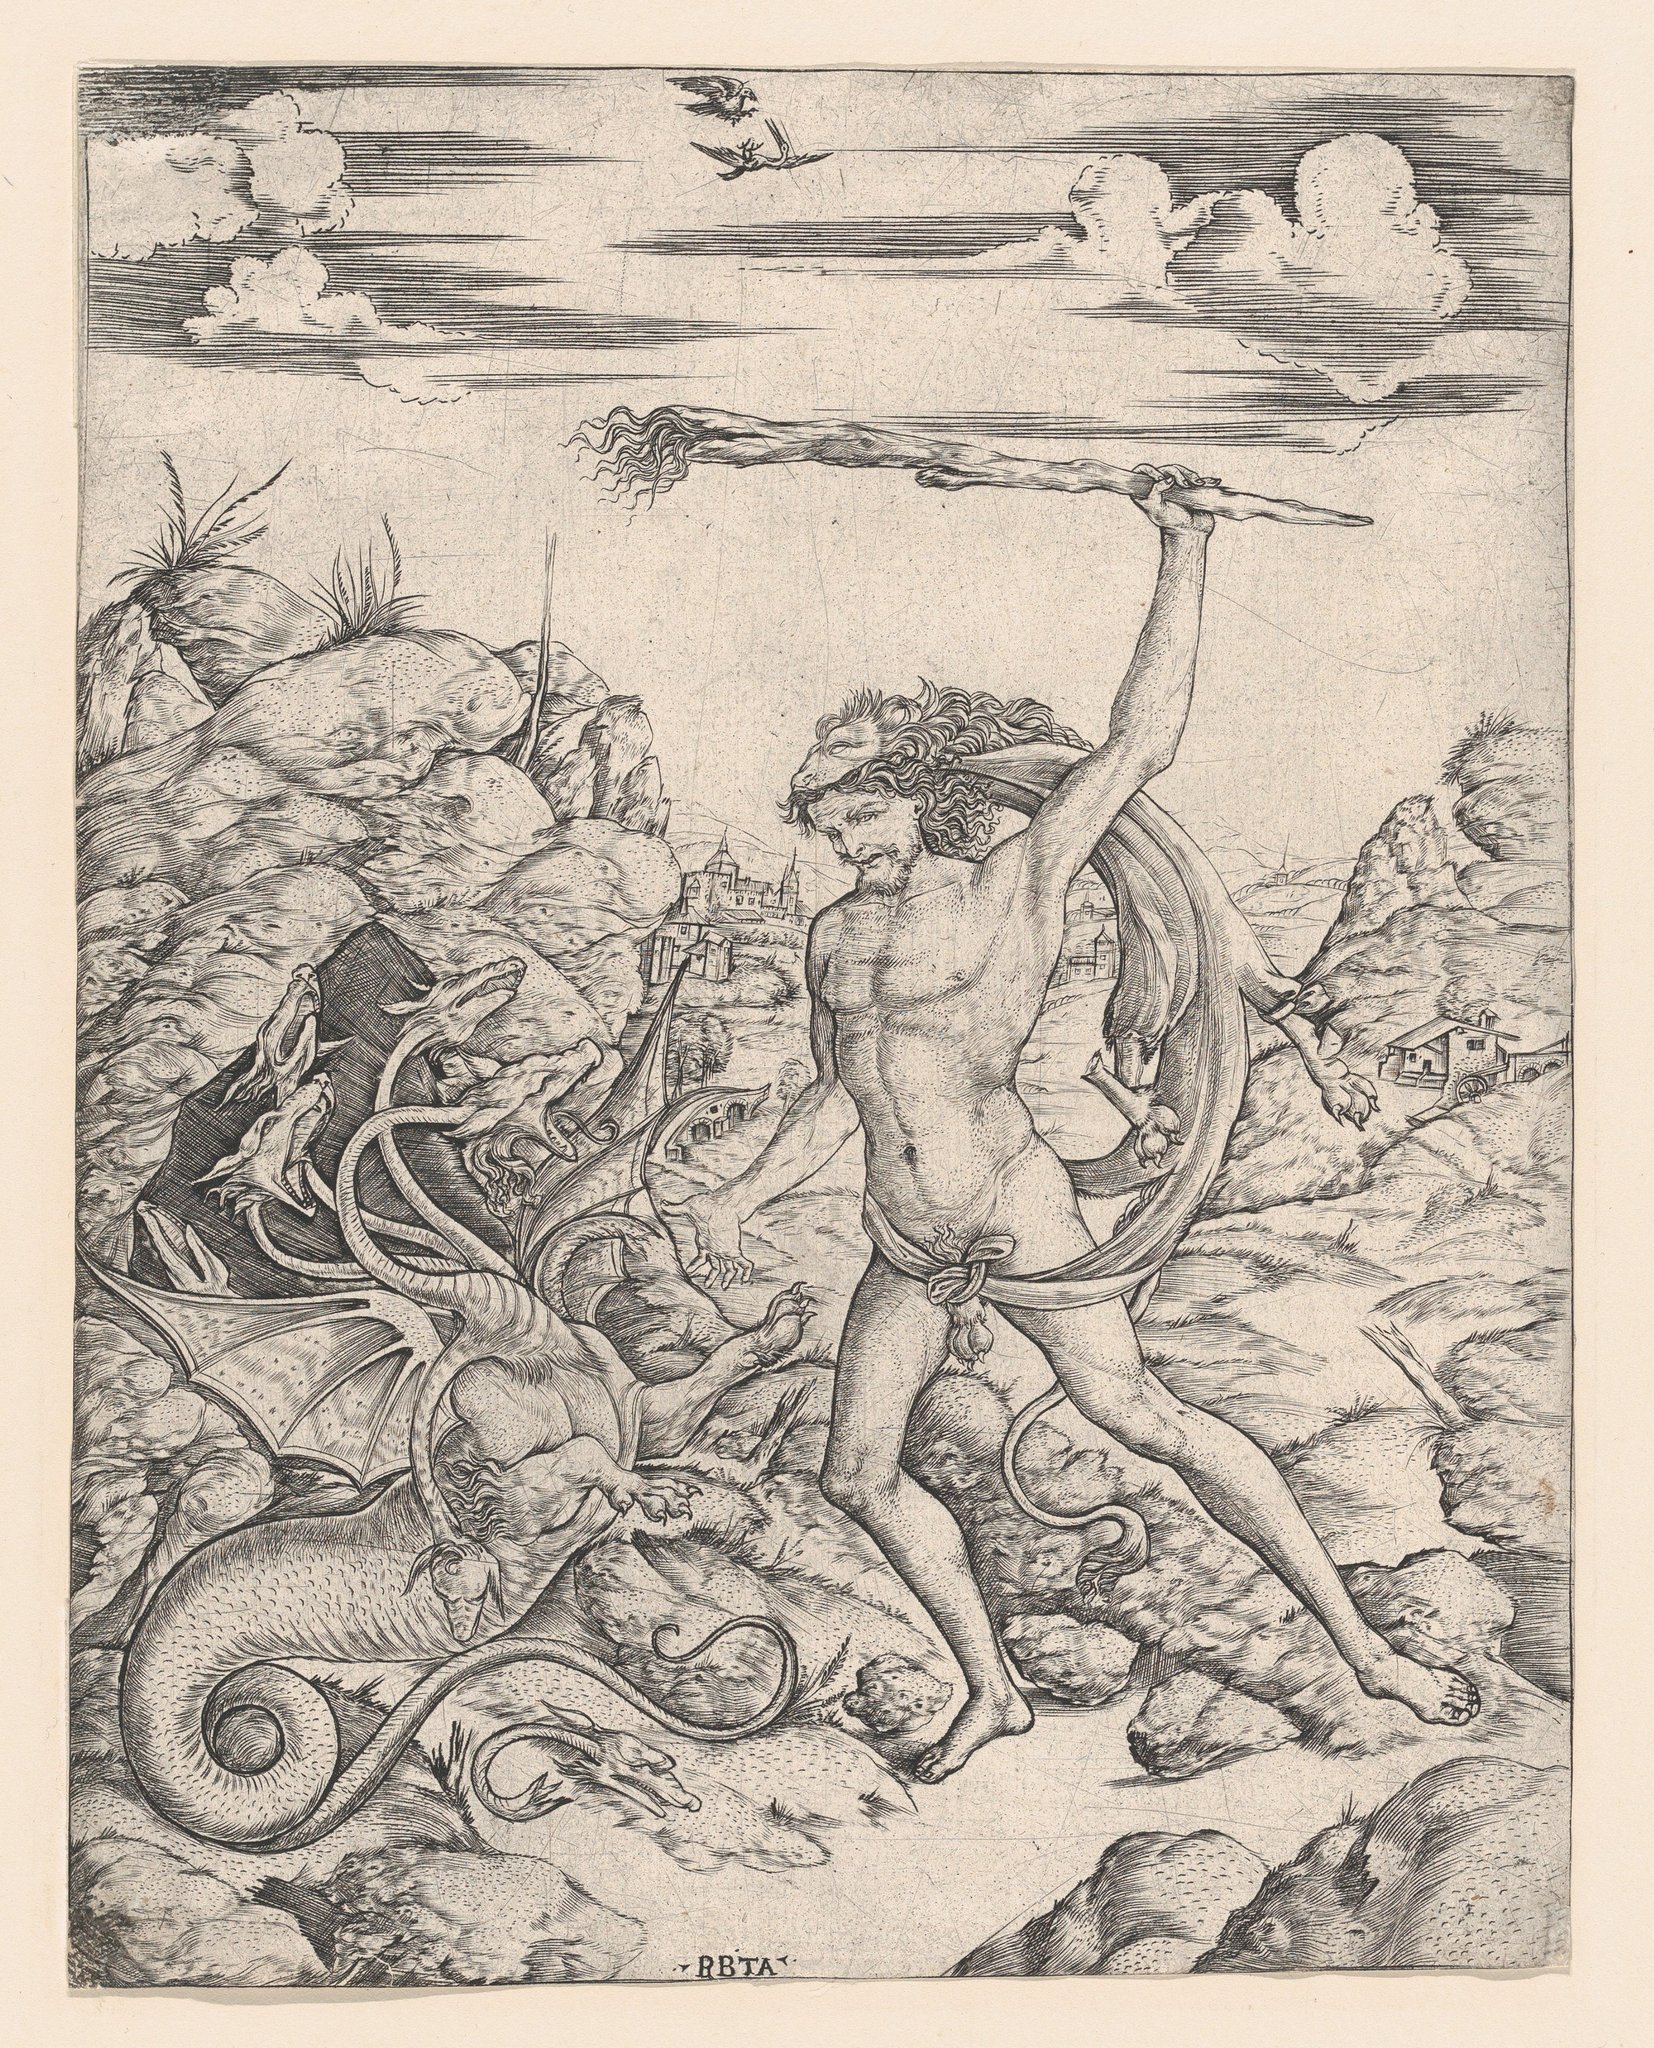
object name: print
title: Hercules and the Hydra; wielding a torch he attacks the winged, multi-headed Hydra in rocky landscape, a hawk attacks a heron in the sky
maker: cristofano robetta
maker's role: artist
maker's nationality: italian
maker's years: 1462-1535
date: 1500-1520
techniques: engraving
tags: hercules,monsters